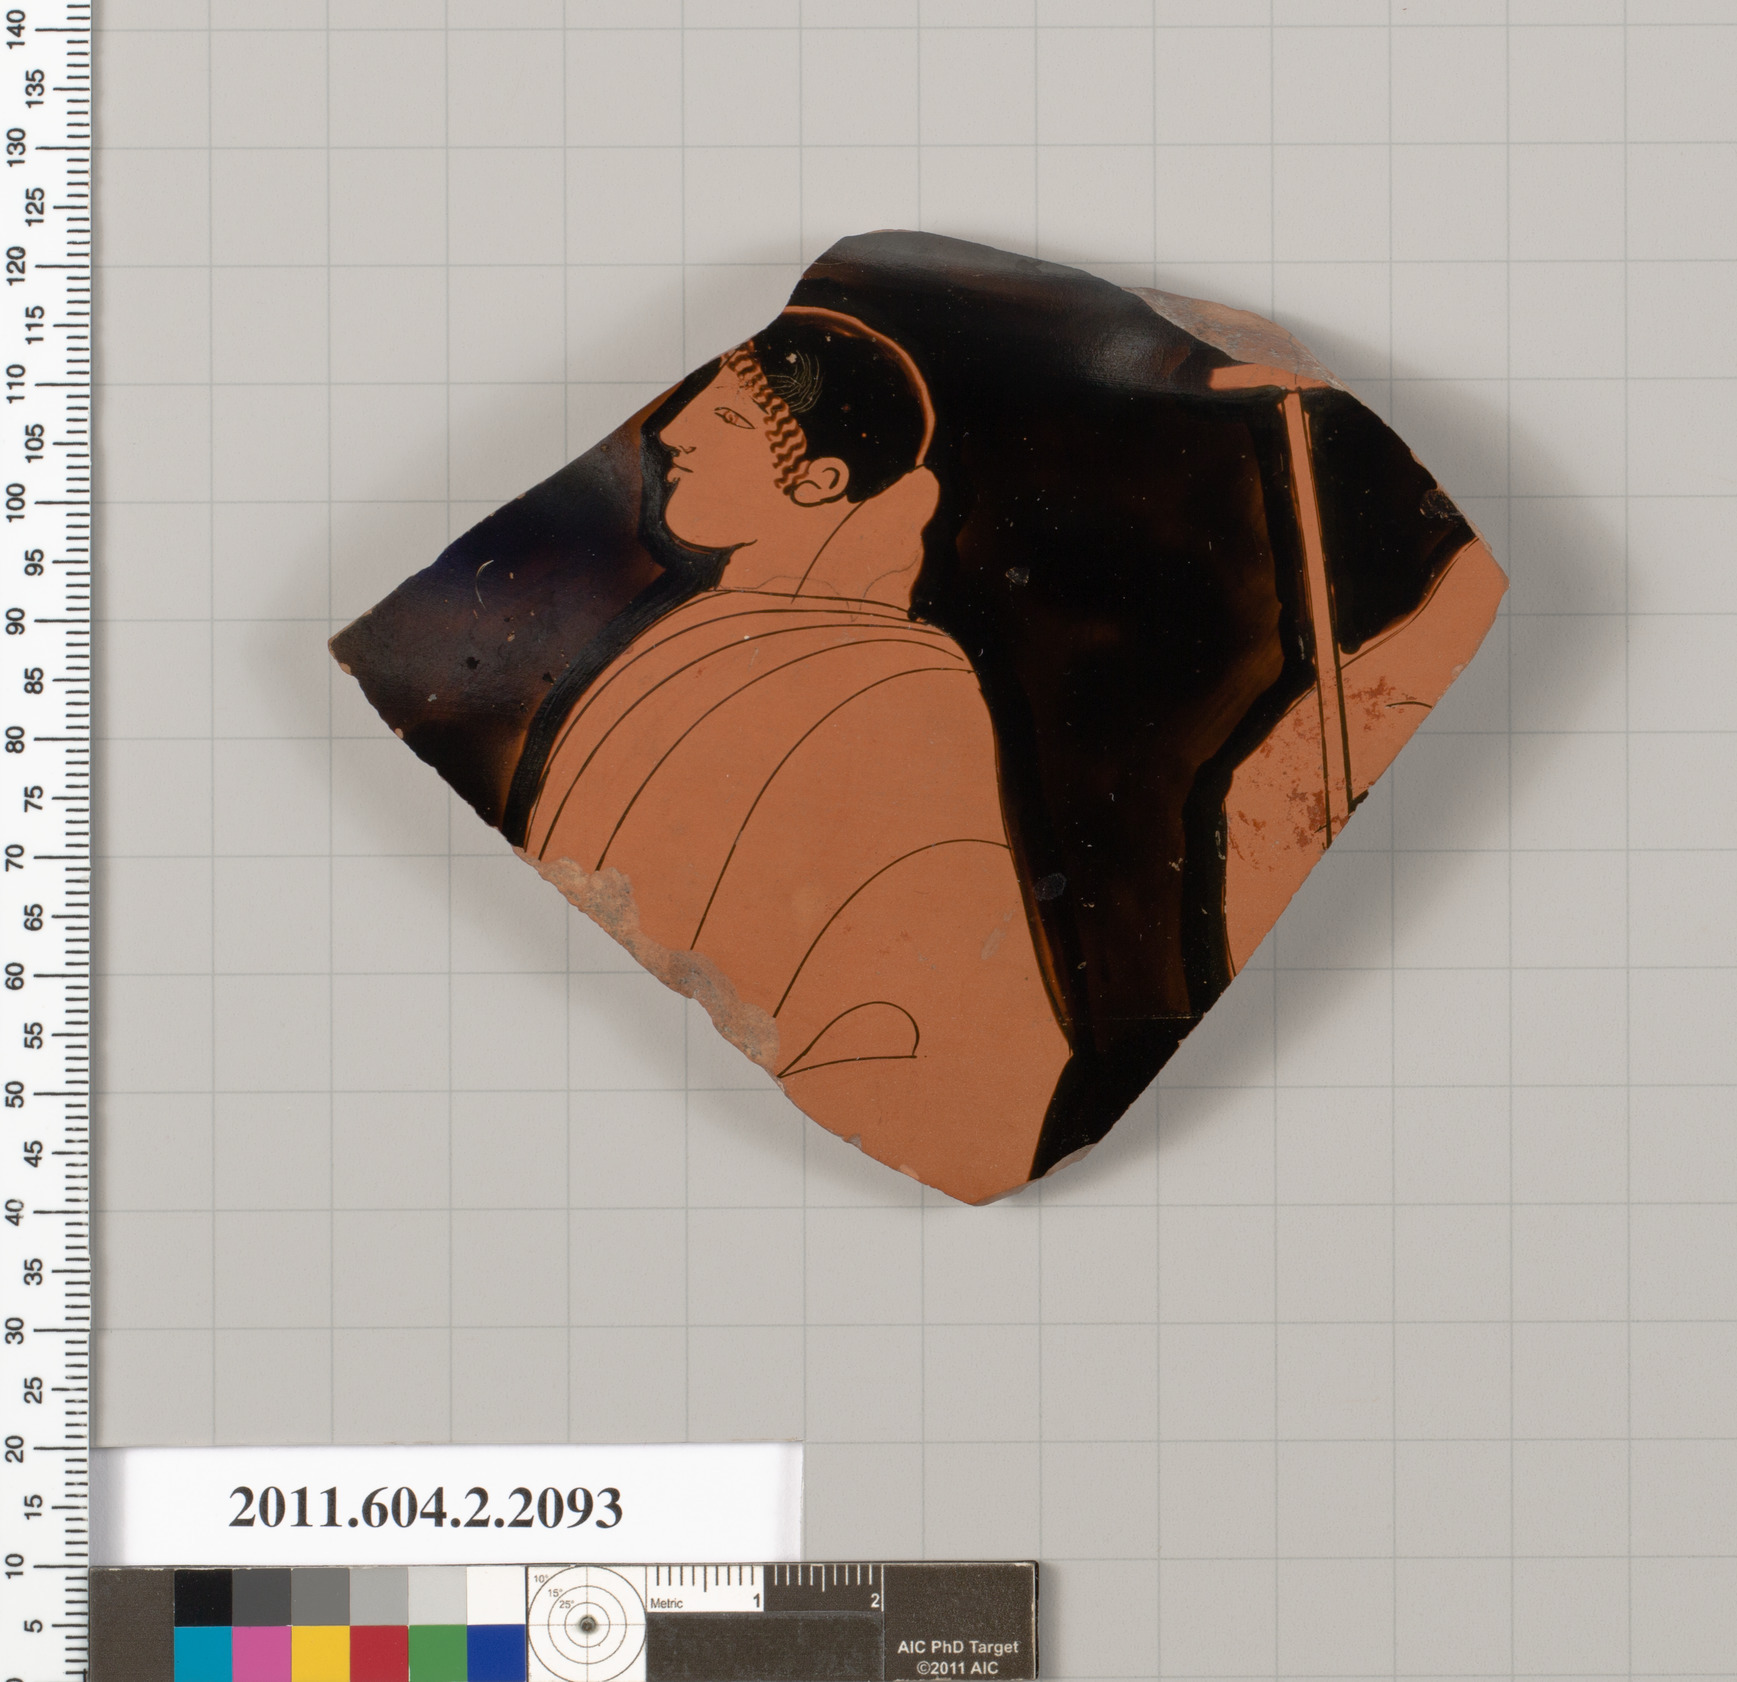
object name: hydria fragment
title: Terracotta fragment of a hydria (water jar)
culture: greek, attic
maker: copenhagen painter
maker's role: artist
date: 490-480 BCE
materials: terracotta